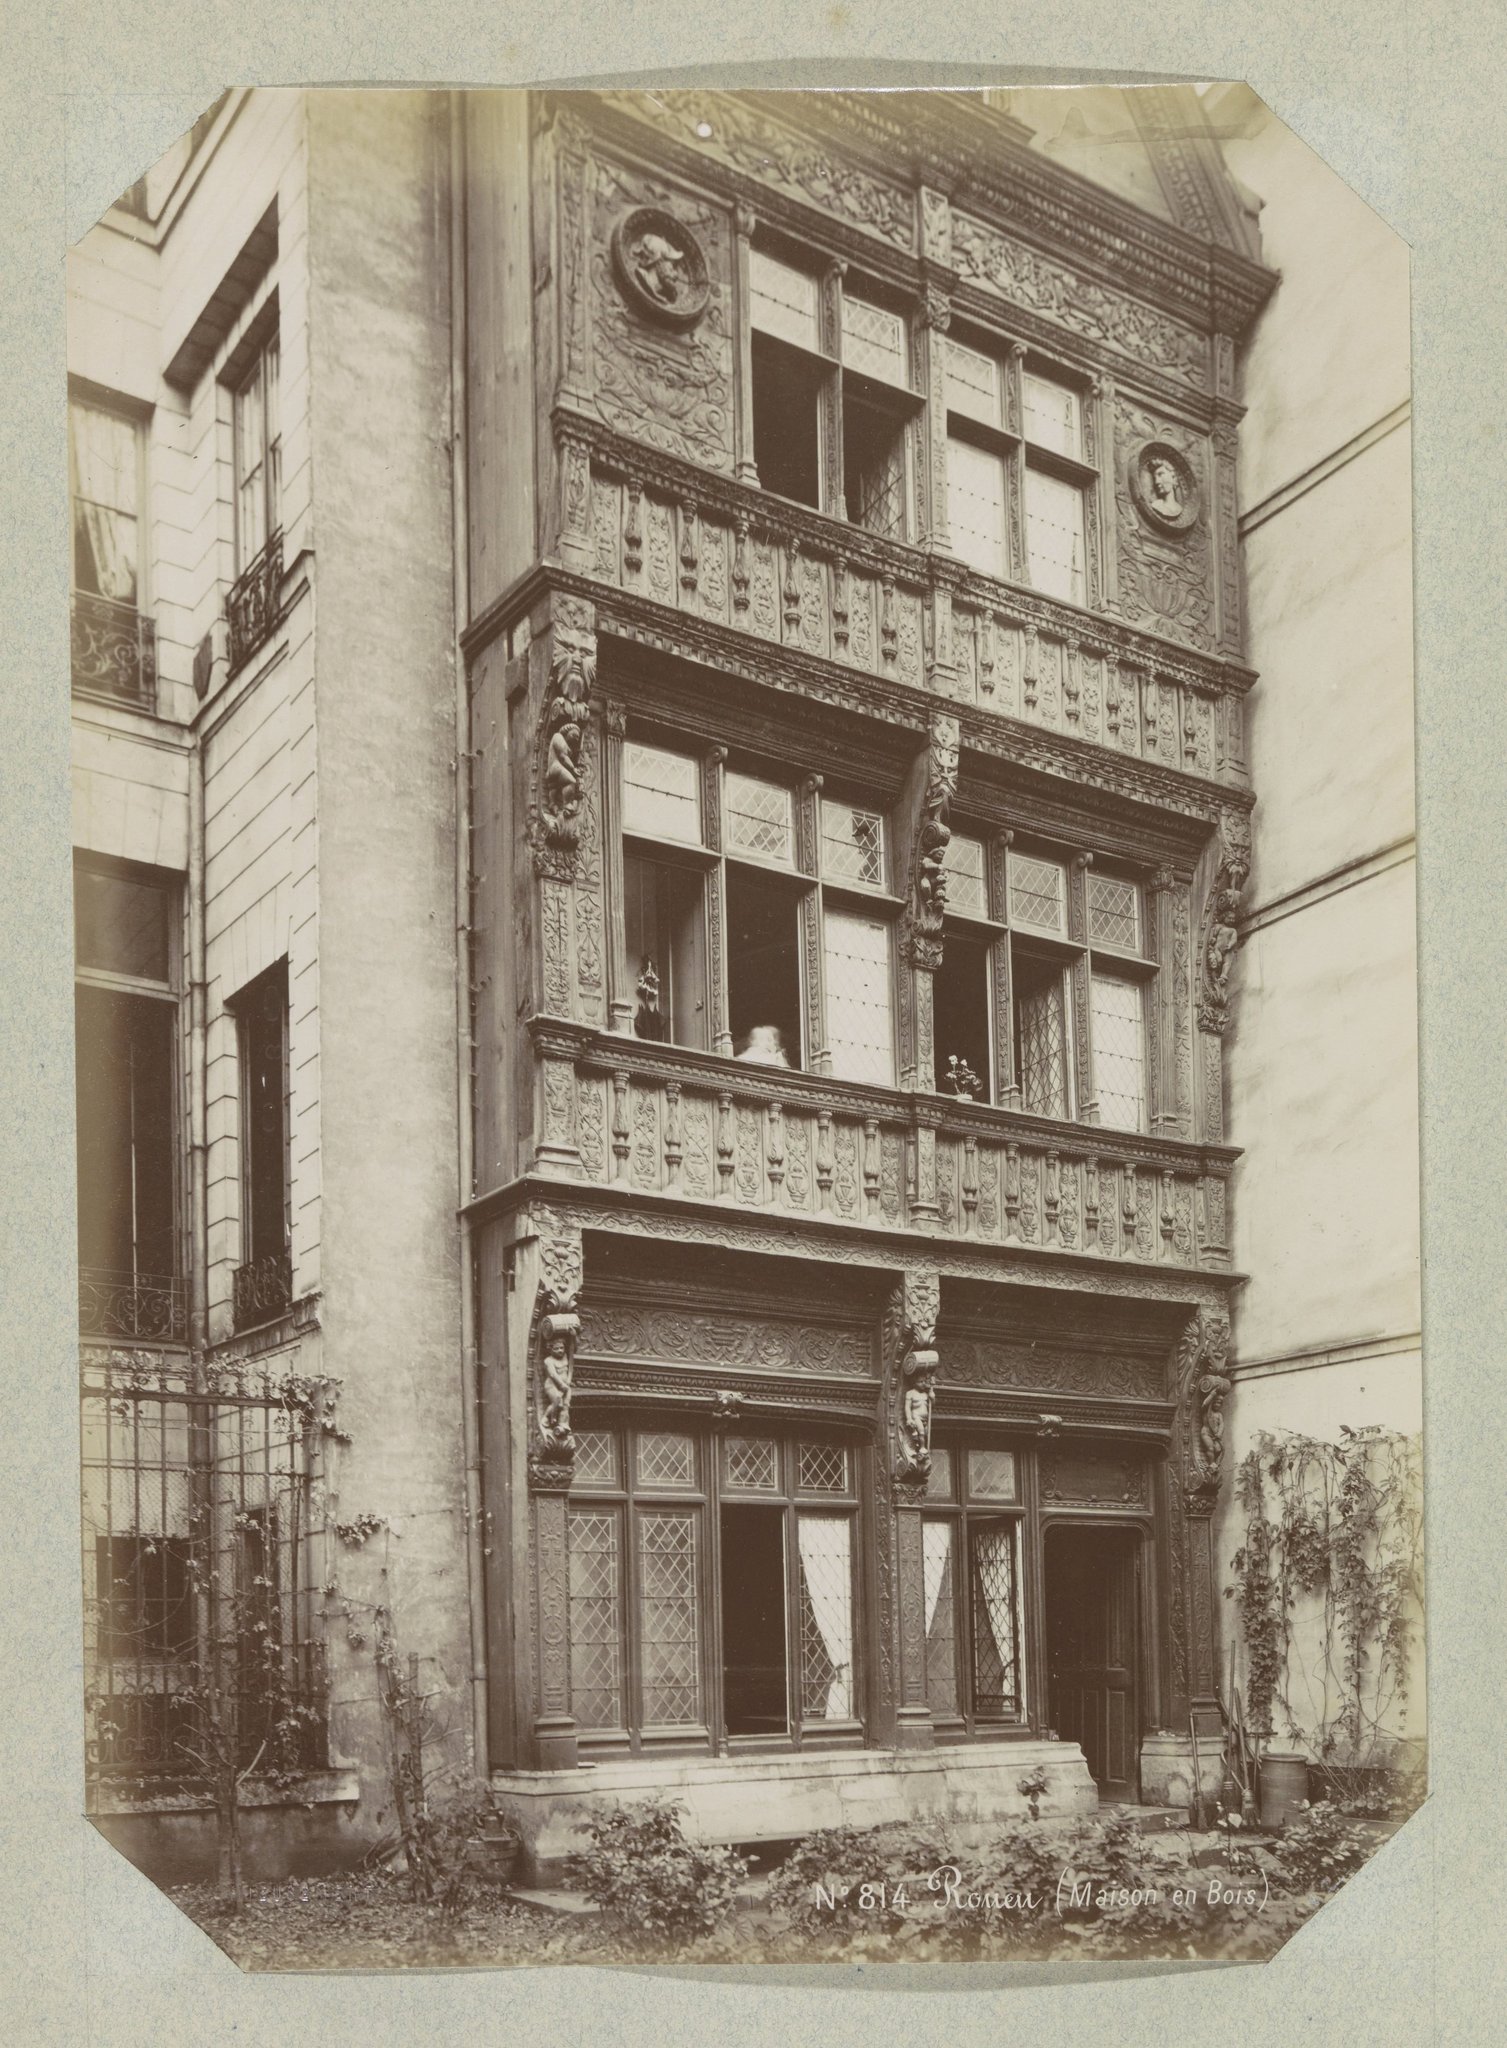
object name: photograph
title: Rouen (Maison en Bois)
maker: séraphin-médéric mieusement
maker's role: fotograaf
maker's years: 1840-1905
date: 1880-1900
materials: photographic support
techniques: albumen print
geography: rouen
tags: façade (of house or building), sculpture (+ relief ~ sculpture)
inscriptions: inscription: ‘Monuments Historiques’, number: ‘814’, name: ‘Mieusement photographe’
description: Onderdeel van Fotoalbum met opnames van monumenten in Frankrijk.